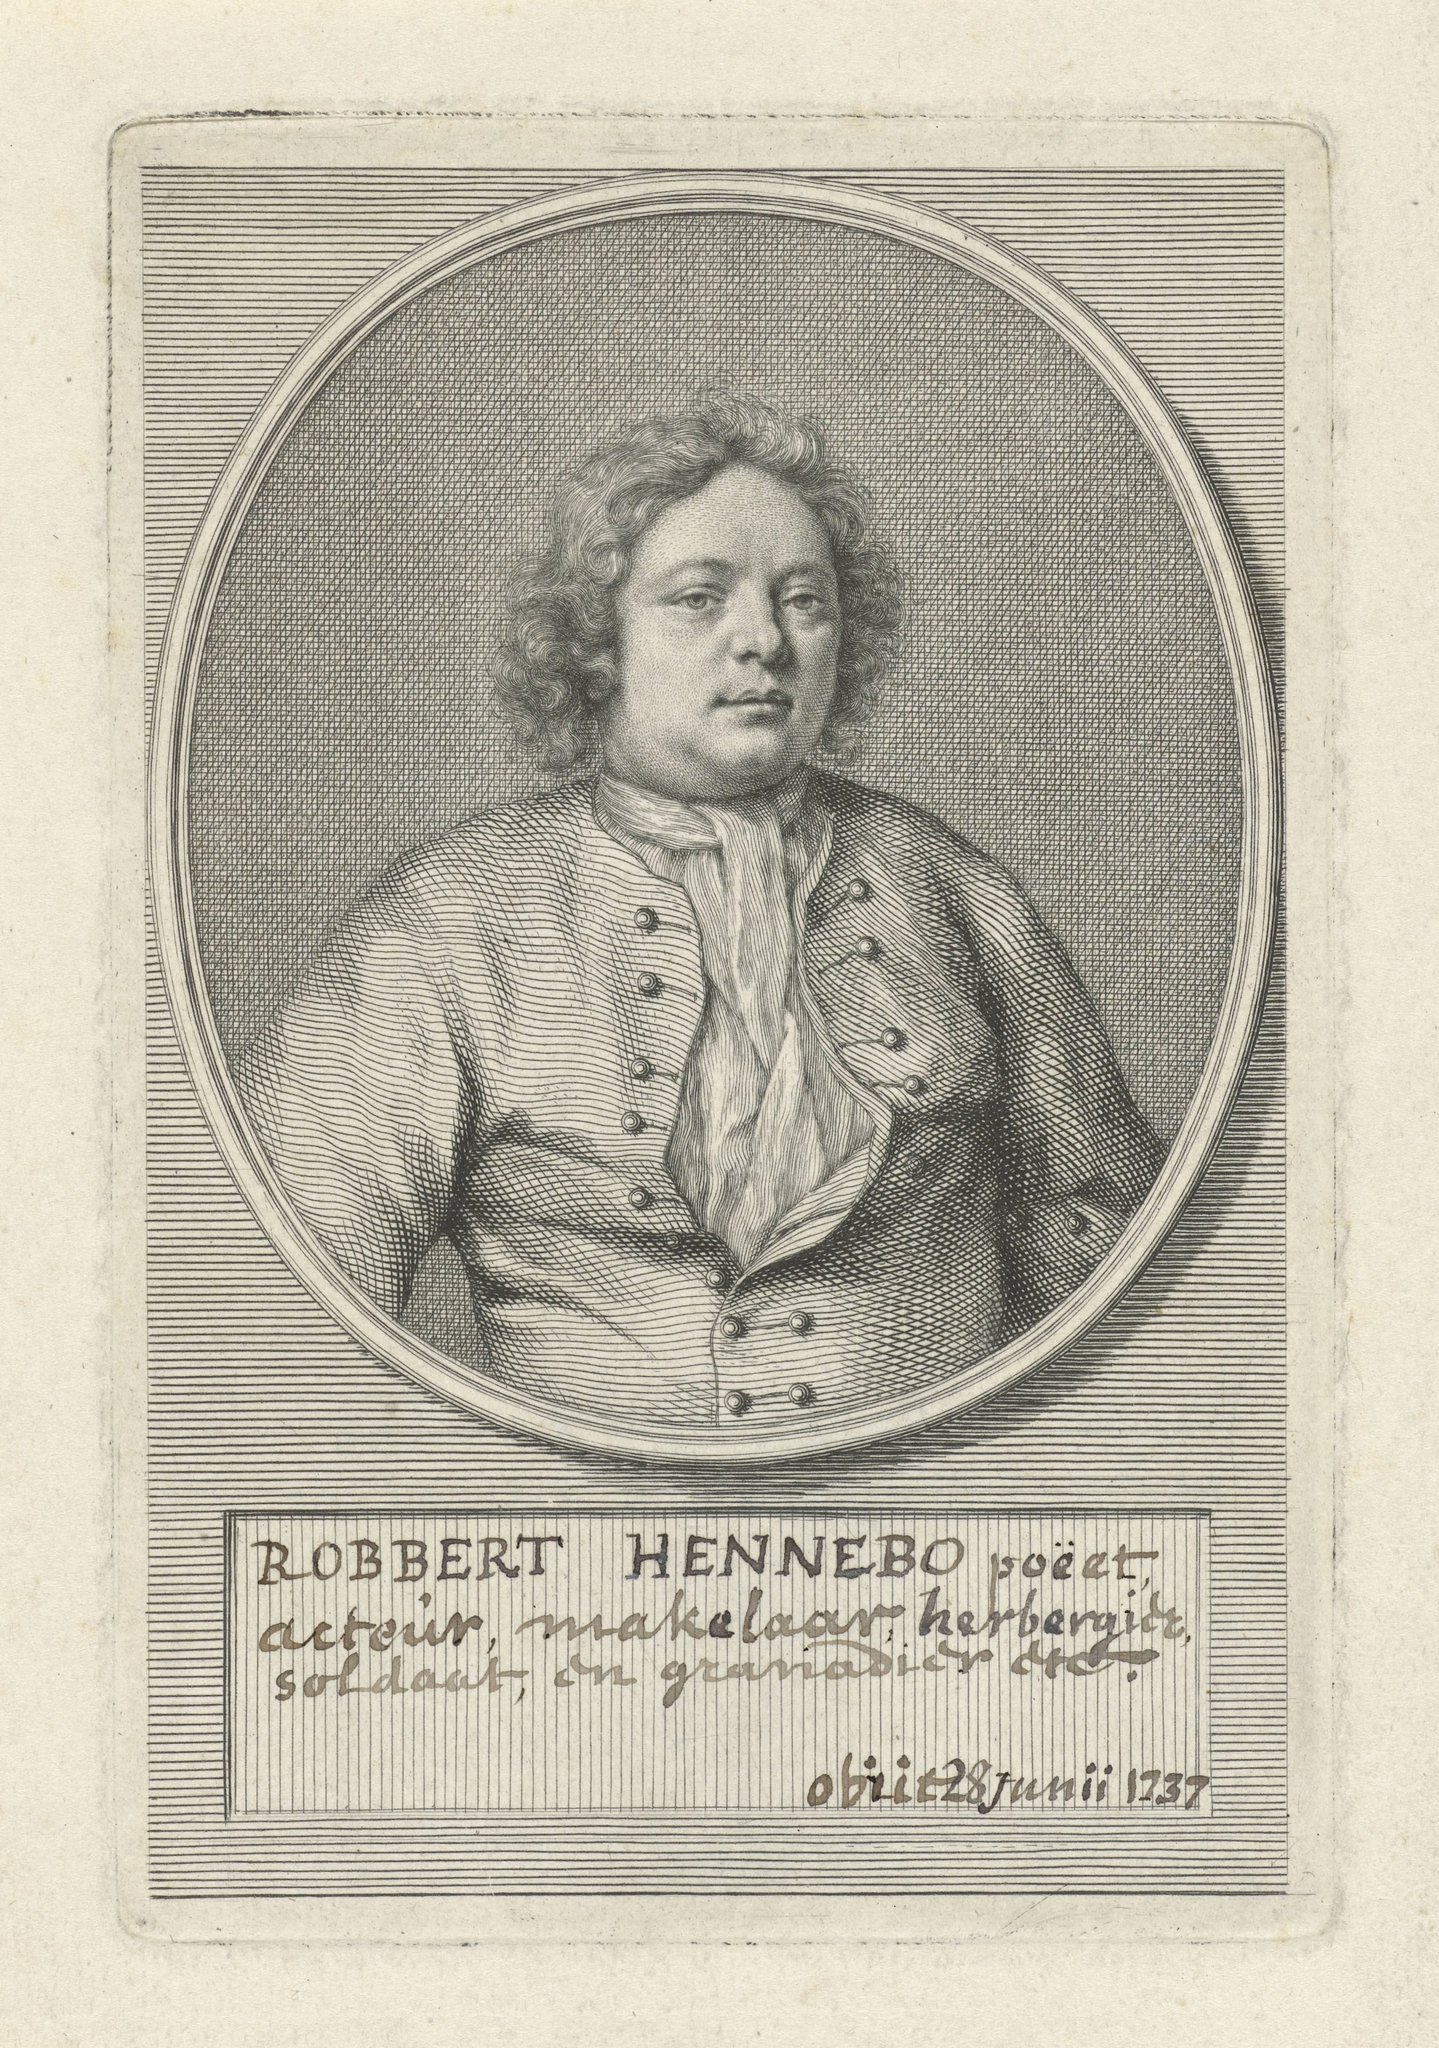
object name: print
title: Portret van Robert Hennebo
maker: jacob houbraken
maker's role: draughtsman, print maker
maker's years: 1698-1780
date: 1737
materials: paper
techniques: engraving, pen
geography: amsterdam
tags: robert hennebo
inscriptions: inscription: ‘Robbert Hennebo poëet,/ acteur, makelaar, herbergier,/ soldaat, en granadier etc./ obiit 28 juni 1737’, collector's mark: Lugt 2228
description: Portret naar rechts van Robert Hennebo in een ovaal. Onder het portret een veld waarin handgeschreven zijn naam en gegevens in drie regels in het Nederlands en rechtsonder zijn overlijdingsdatum.